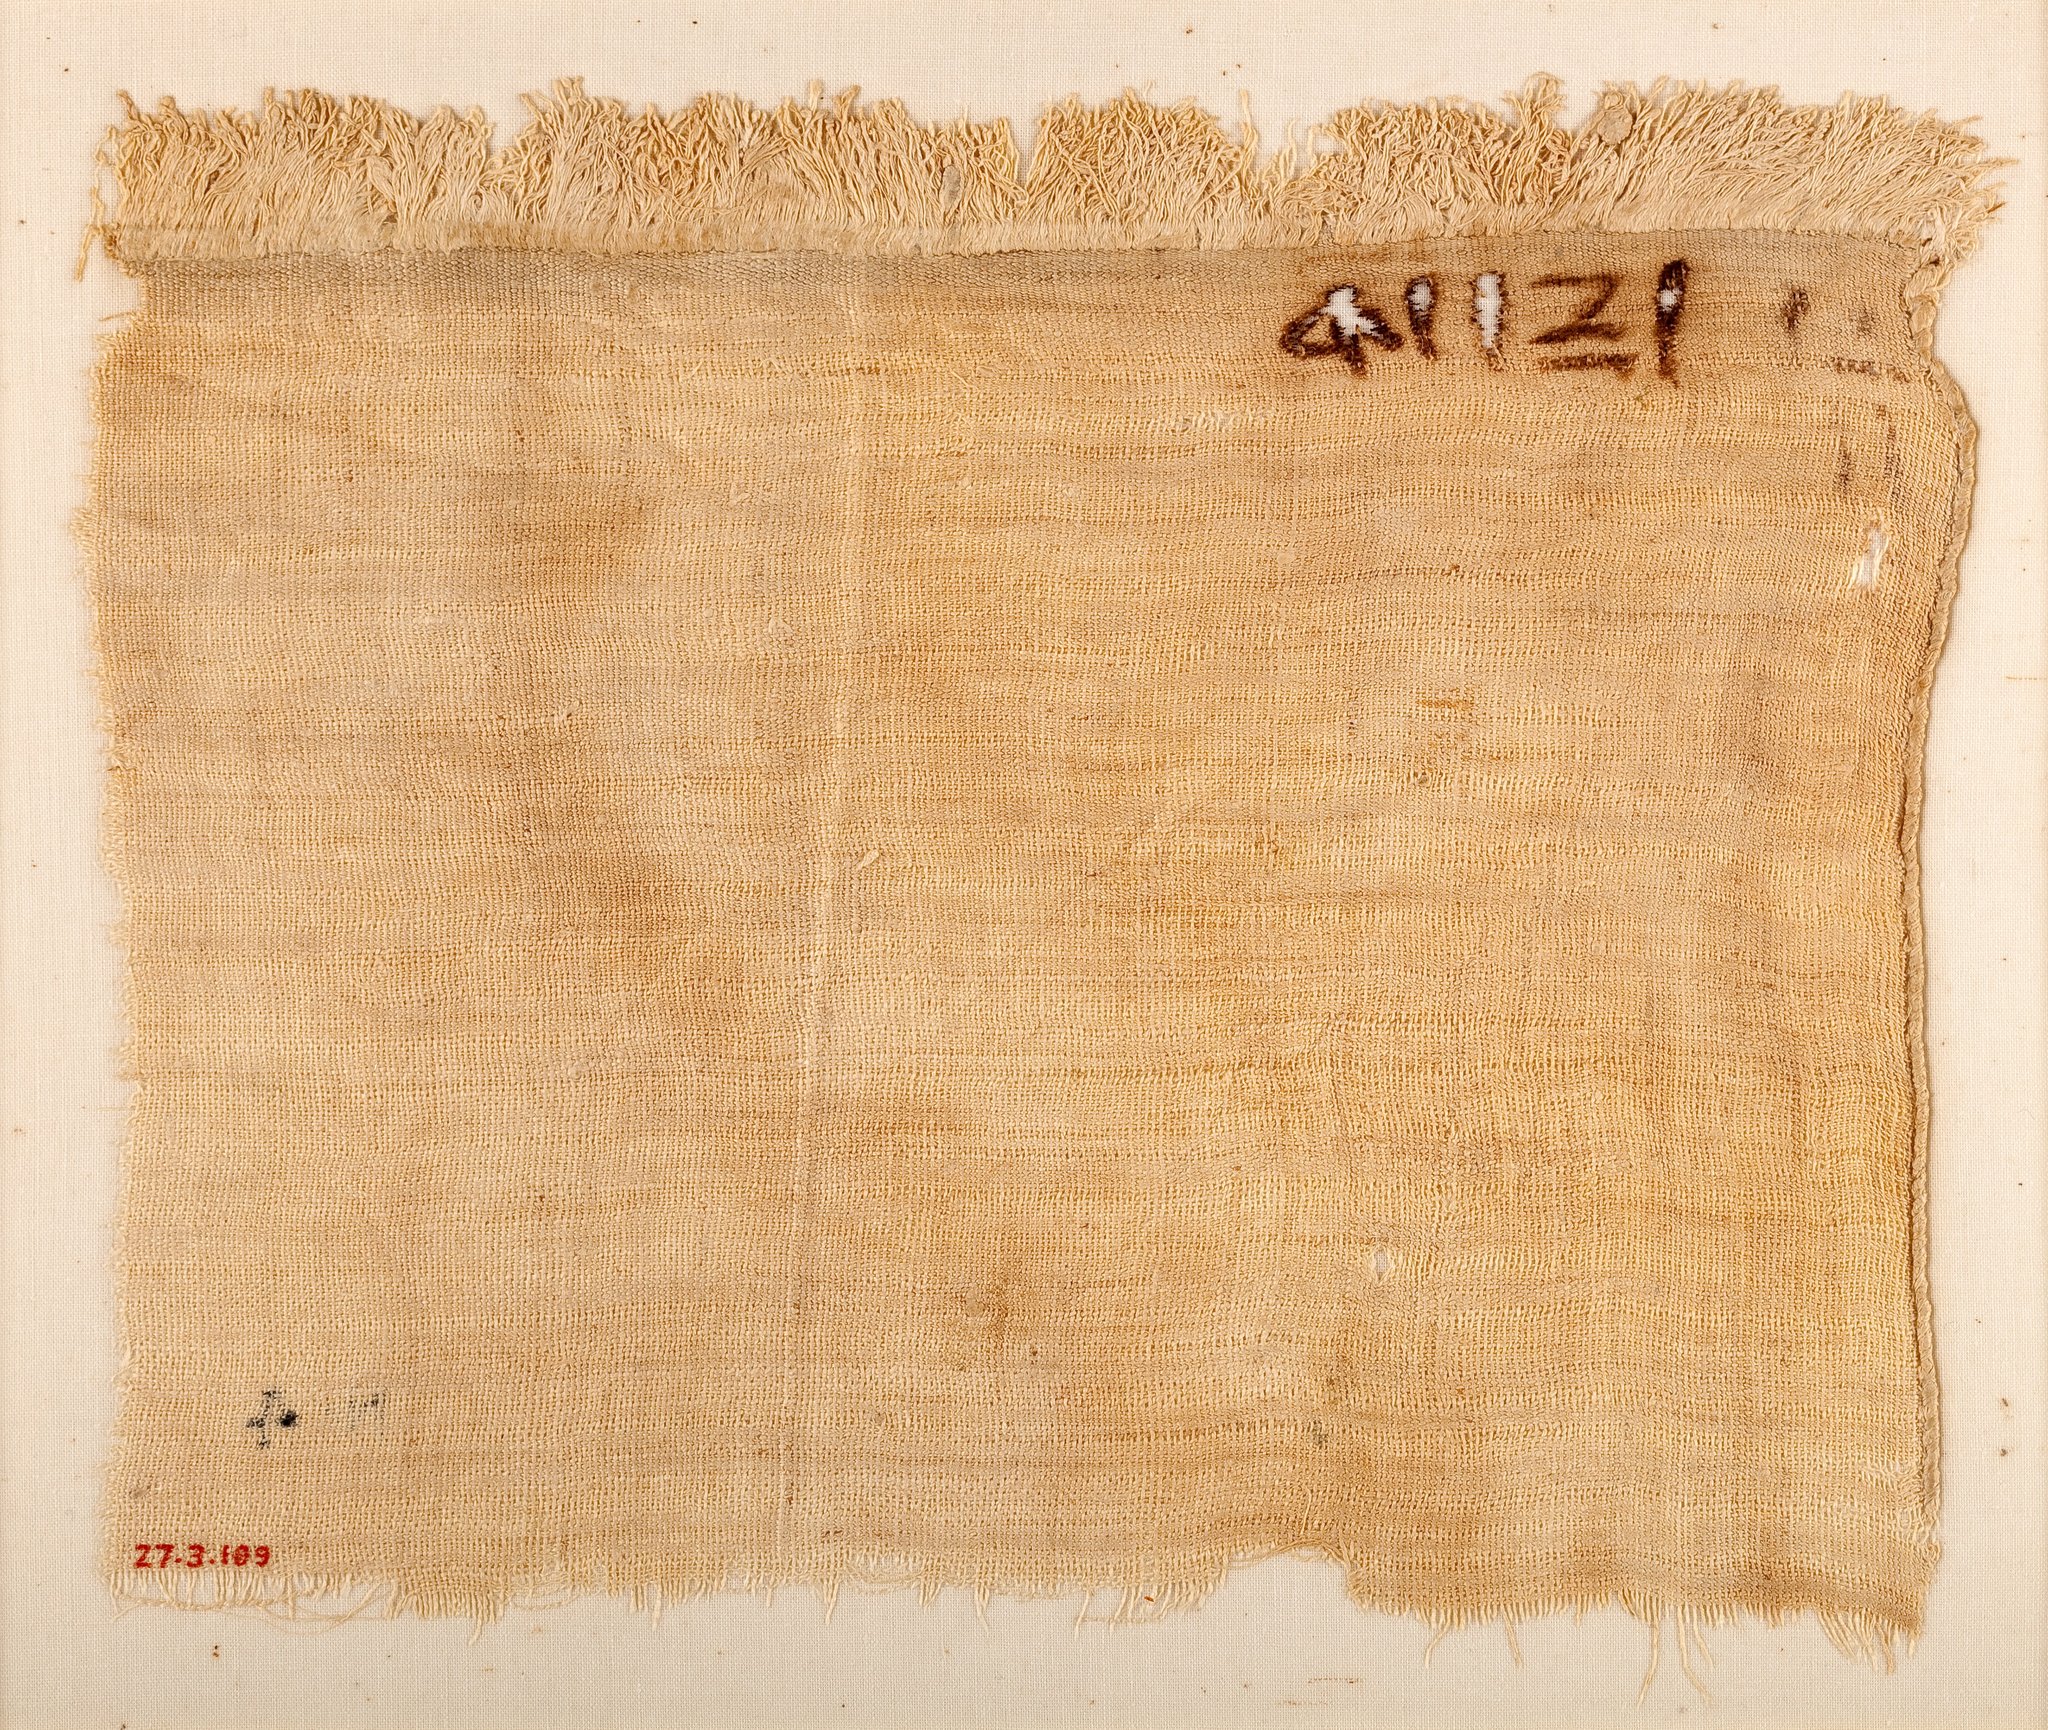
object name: linen mark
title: Linen mark (Type XIII)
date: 1961-1917 BCE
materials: linen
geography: egypt